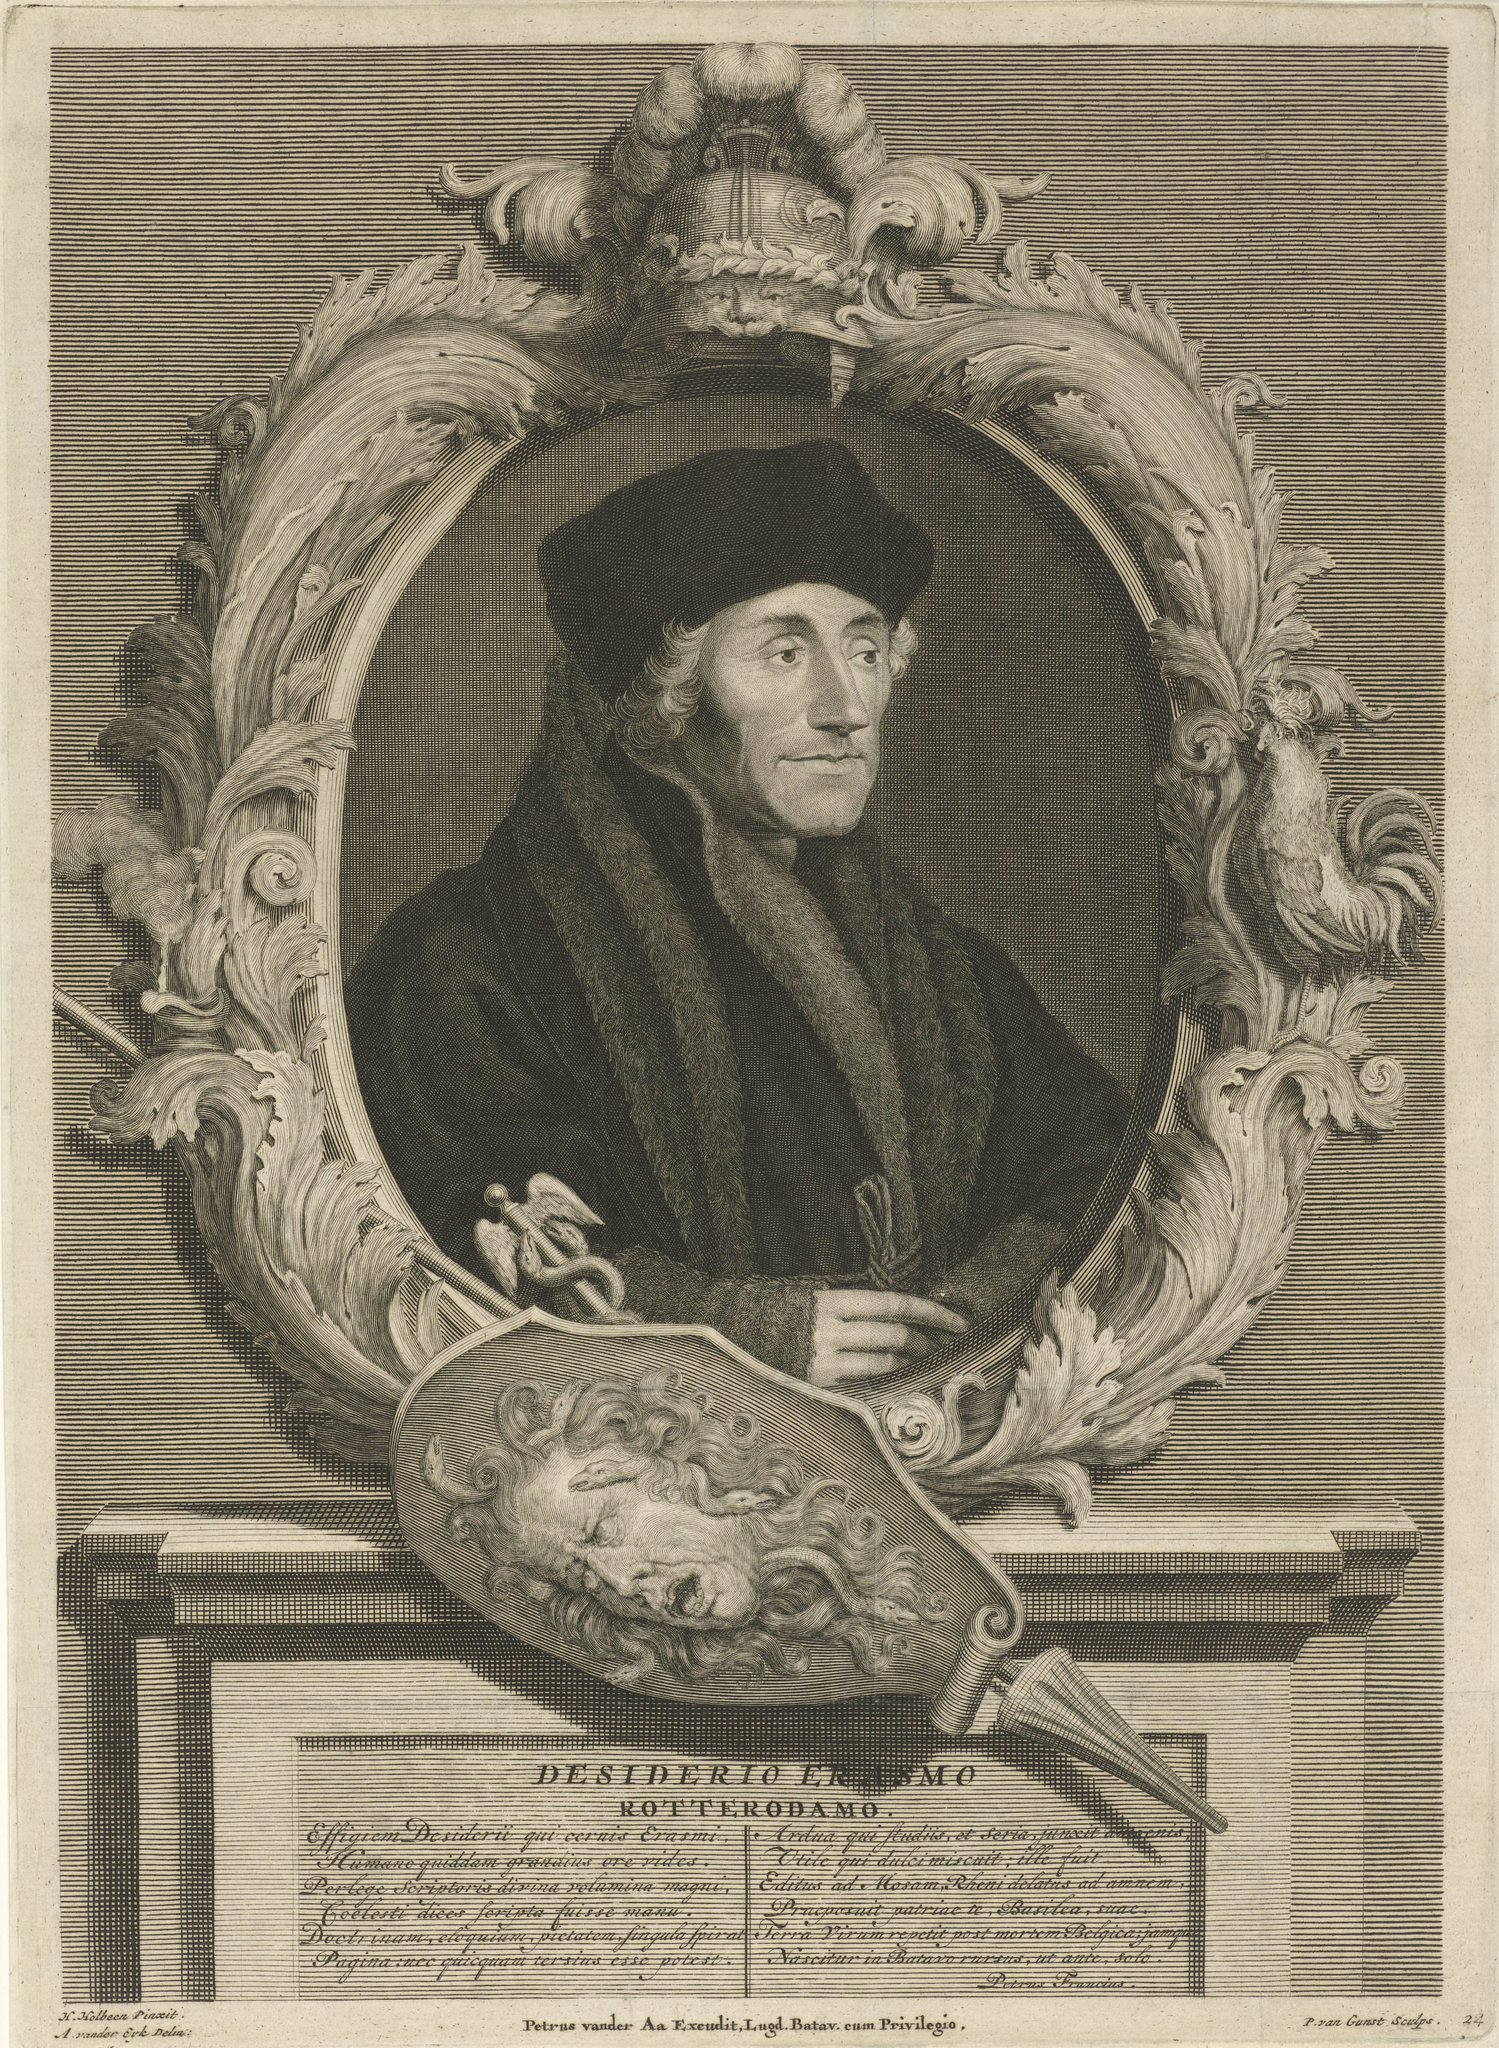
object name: print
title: Portret van Desiderius Erasmus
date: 1659-1731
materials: paper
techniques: engraving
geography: amsterdam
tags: rotterdam, desiderius erasmus, caduceus (staff with two snakes, attribute of mercury), aegis: shield with gorgon's head (attribute of minerva)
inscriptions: number: ‘24’, collector's mark: Lugt 2228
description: Desiderius Erasmus, humanist uit Rotterdam. Onder het portret een caduceus en een schild met het hoofd van Medusa. De prent heeft een Latijns onderschrift.